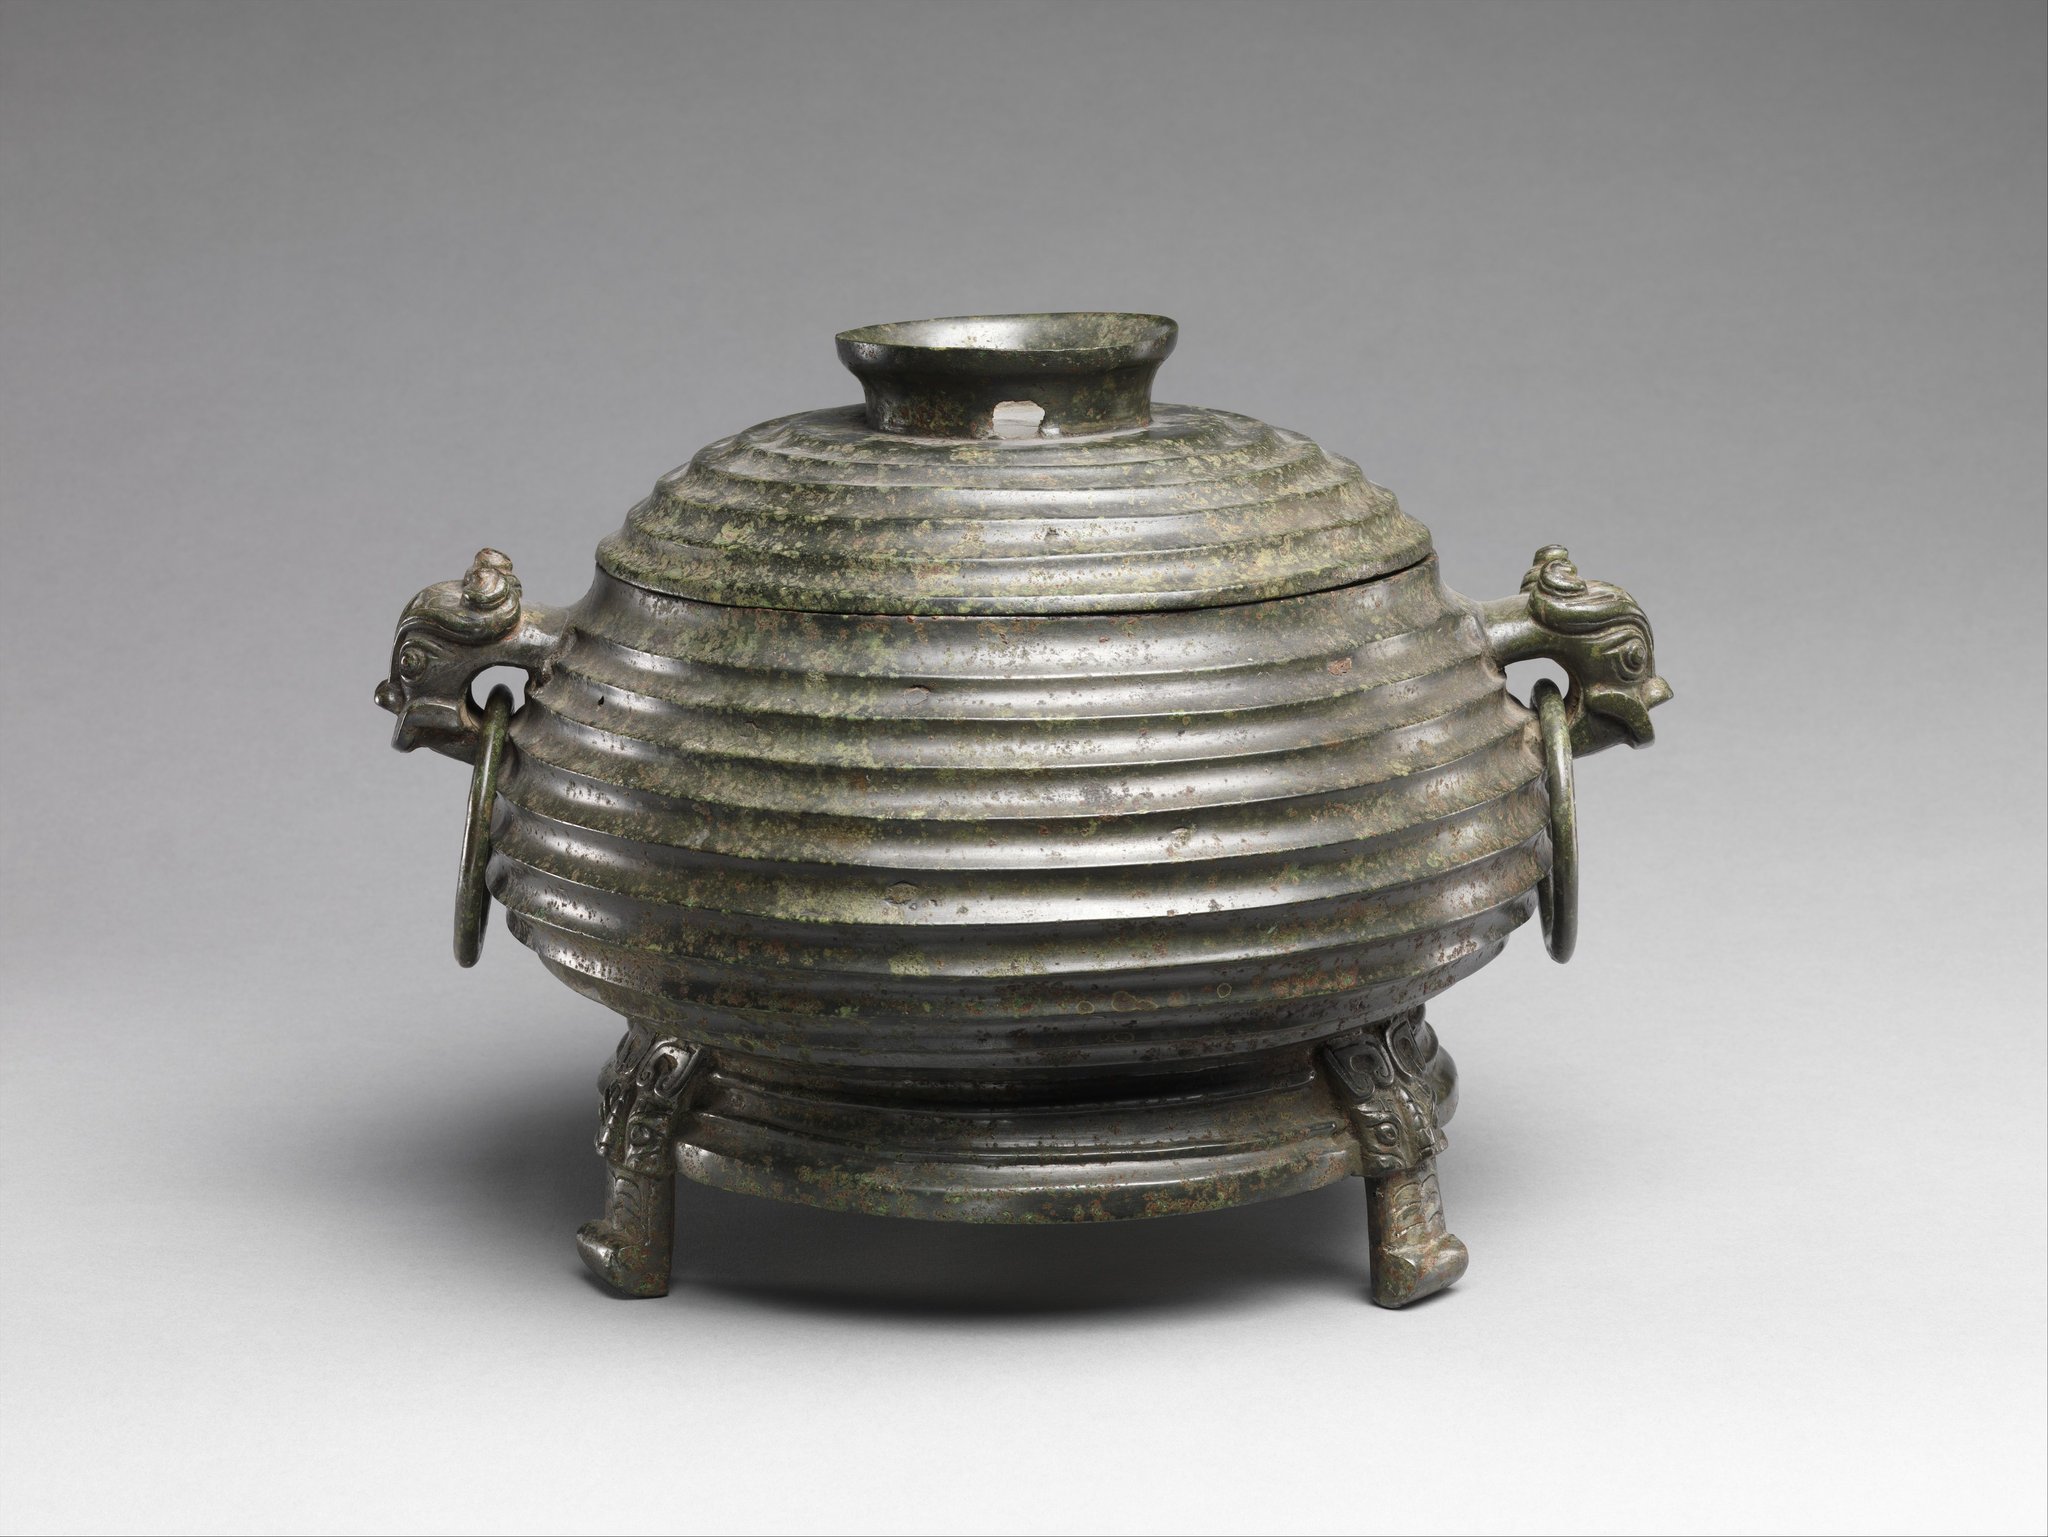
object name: grain vessel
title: Grain serving vessel (gui)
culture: chinese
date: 900-868 BCE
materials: bronze